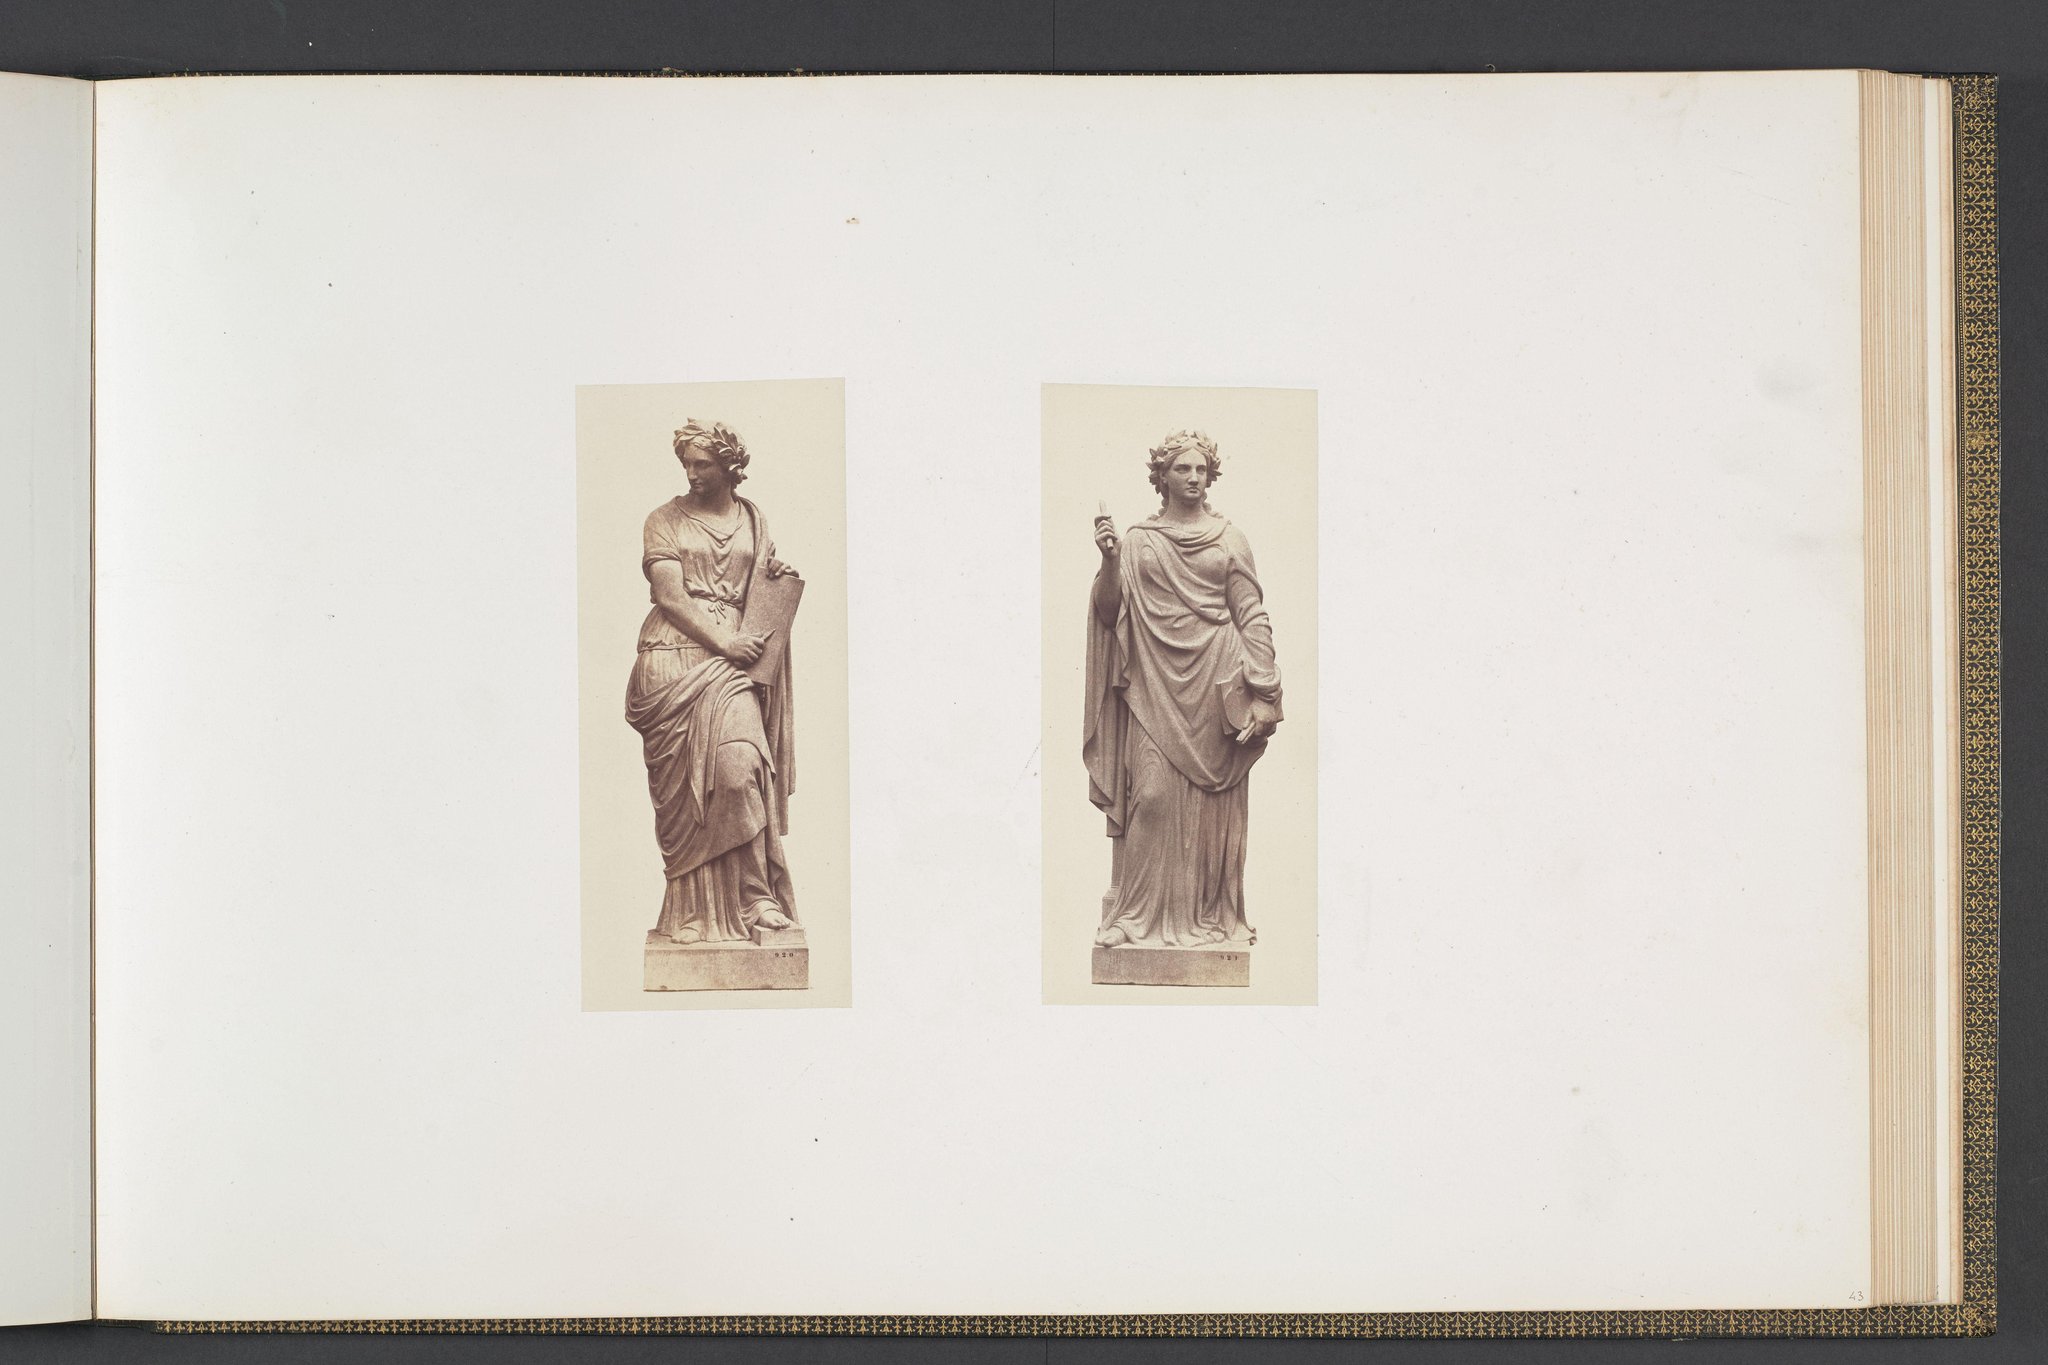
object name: album leaf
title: Gipsmodellen voor beeldhouwwerken op het Palais du Louvre: links "La Gravure" door Jules Droz en rechts "La Peinture" door Jean Louis Nicolas Jaley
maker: édouard denis baldus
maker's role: fotograaf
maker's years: 1813-1889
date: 1855-1857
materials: paper, photographic support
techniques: salted paper print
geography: paris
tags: piece of sculpture, reproduction of a piece of sculpture, permanent exhibition, museum, paris, tuileries palace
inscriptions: number: ‘920 en 921’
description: Onderdeel van Réunion des Tuileries au Louvre 1852-1857, album 3.